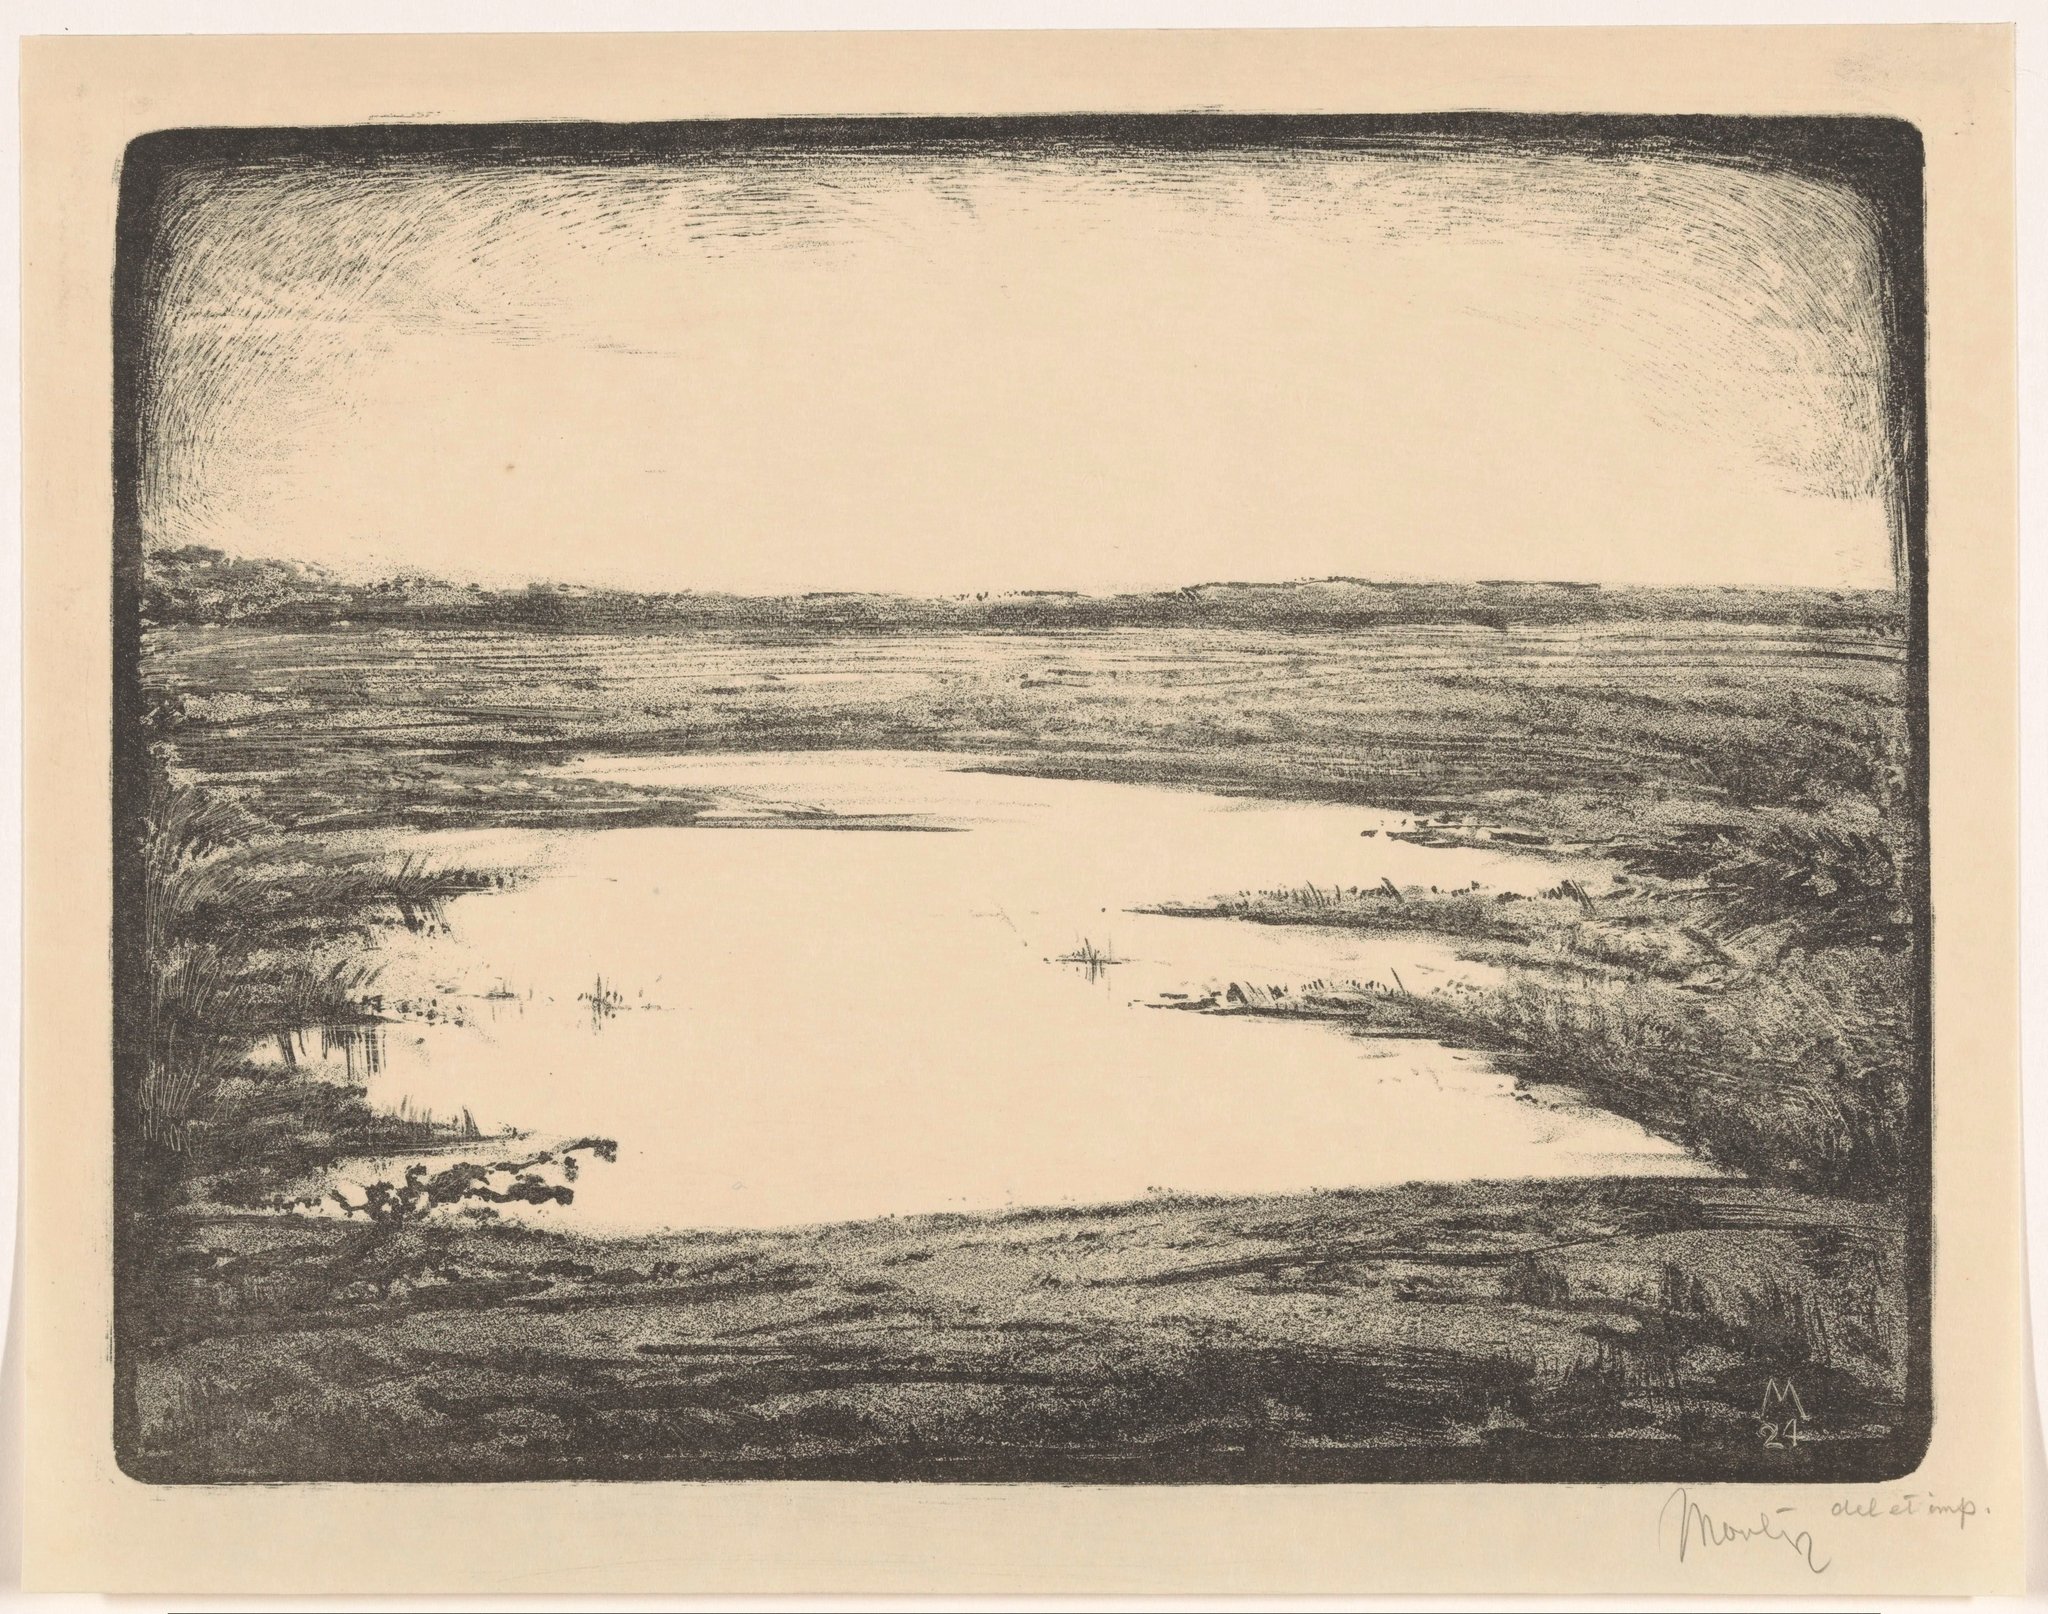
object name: print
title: Vlak landschap met ven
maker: simon moulijn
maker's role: draughtsman, print maker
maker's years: 1866-1948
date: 1924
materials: paper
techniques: lithograph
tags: fen, du. 'ven'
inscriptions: collector's mark: Lugt 2228